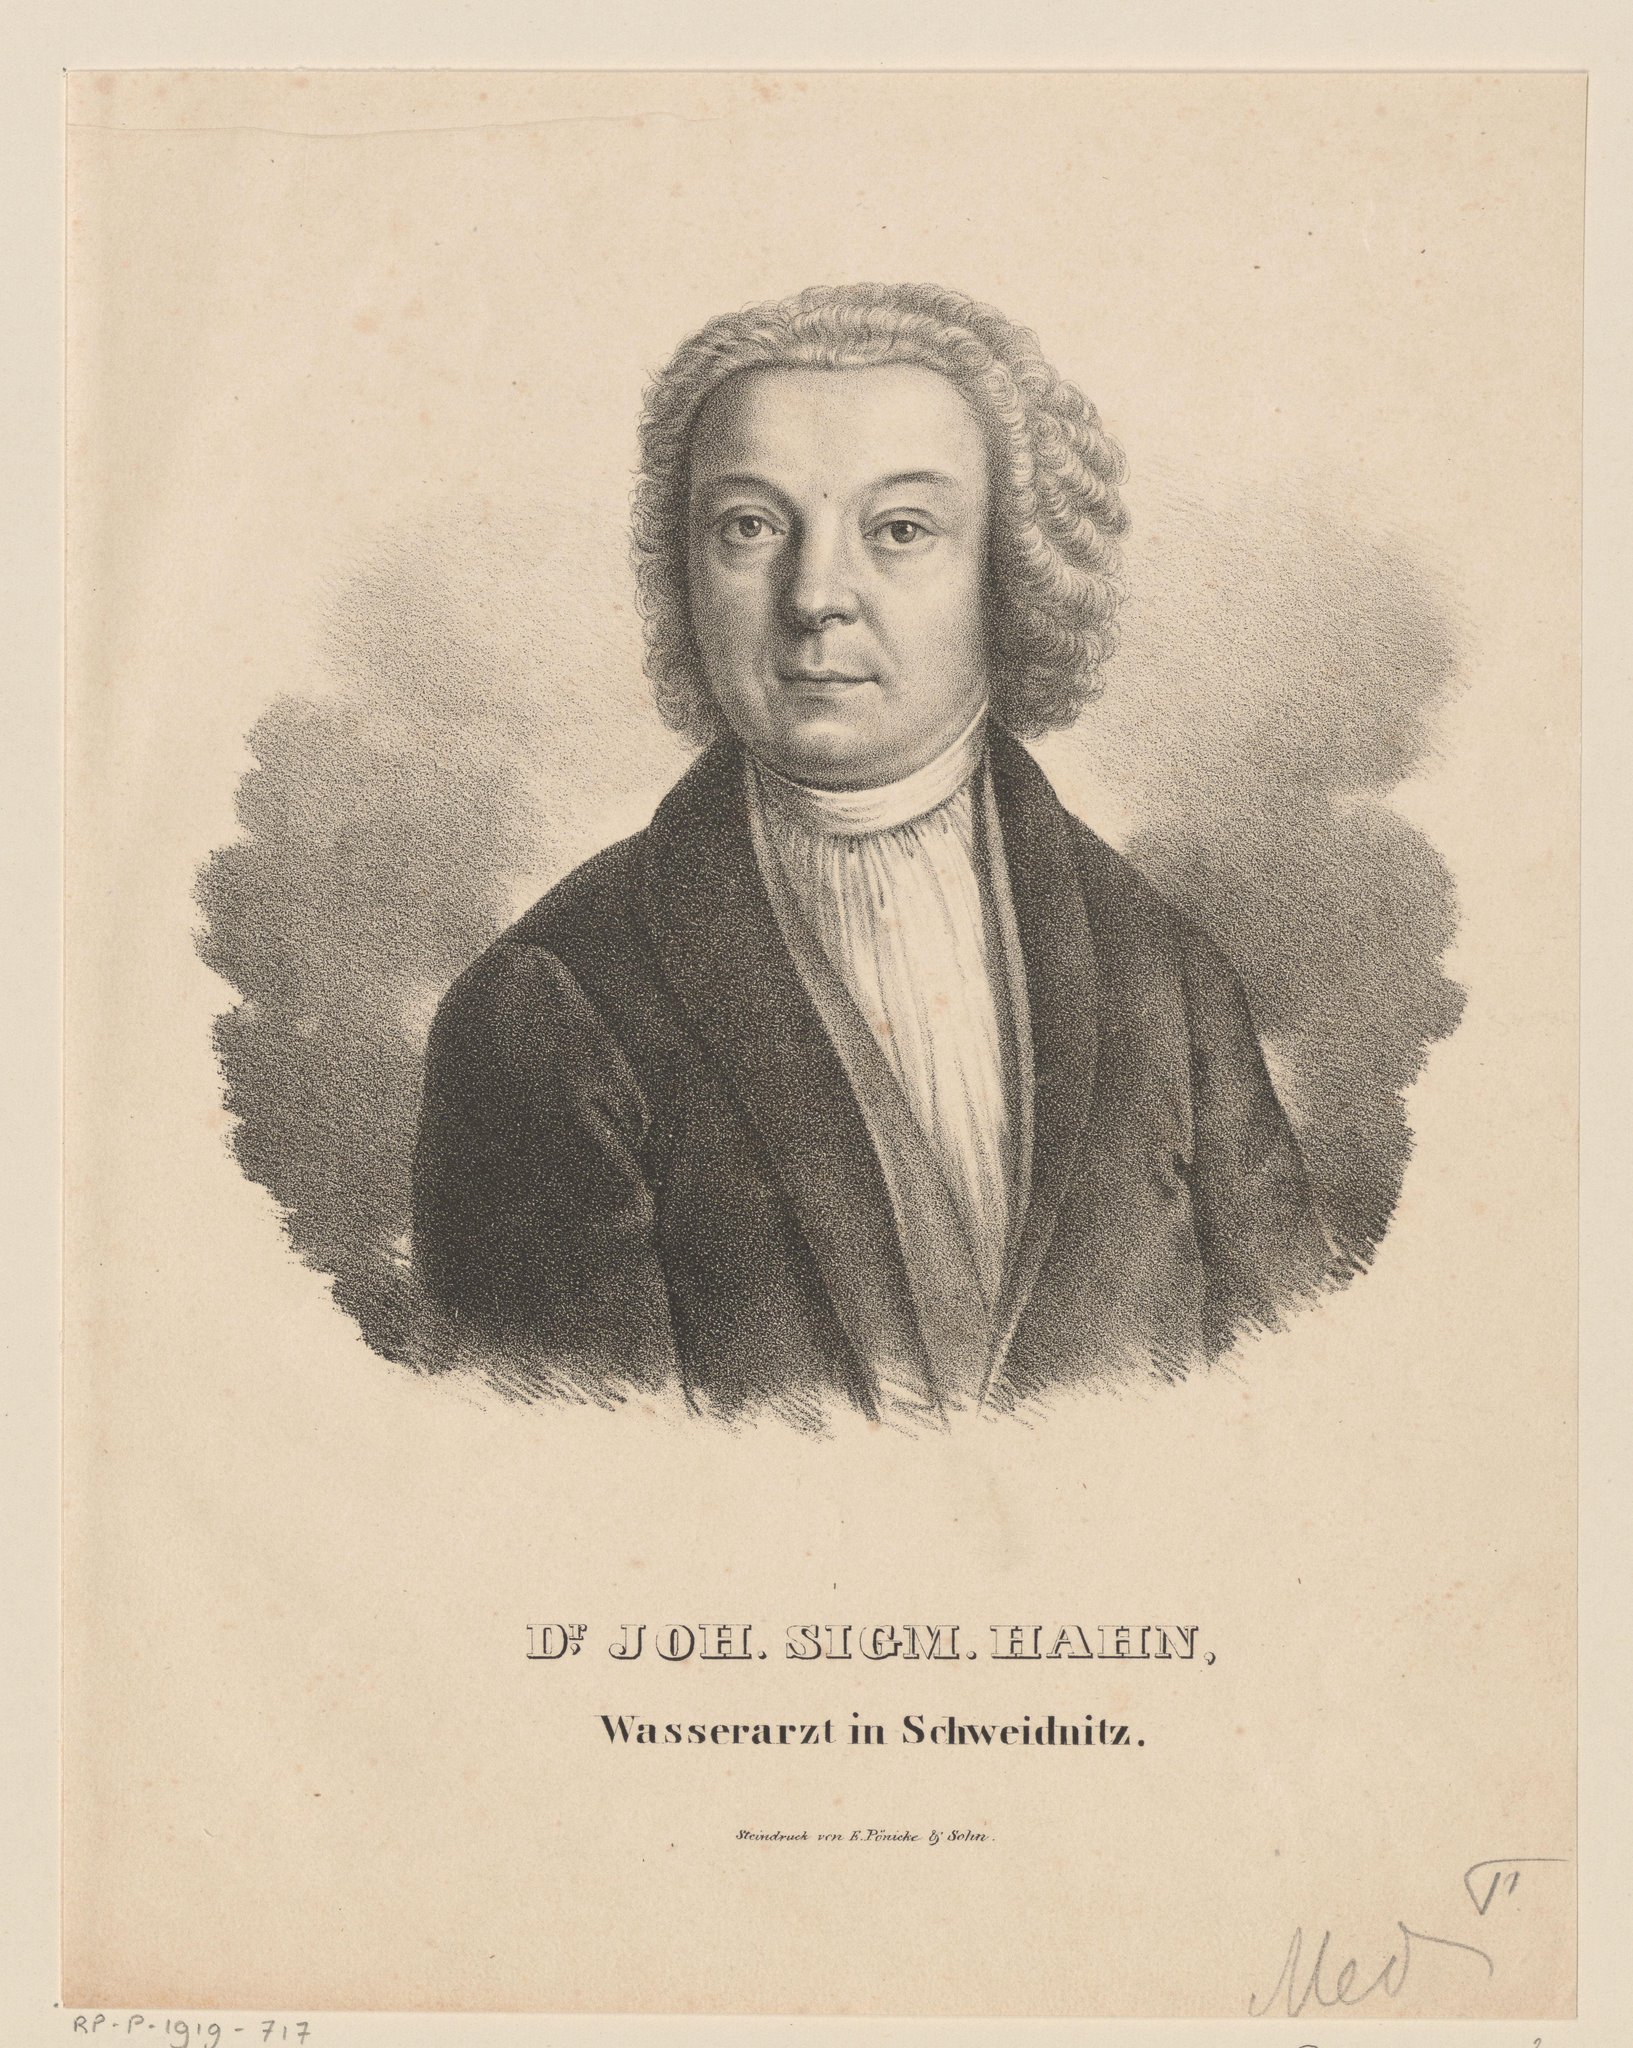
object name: print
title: Portret van Johann Siegmund Hahn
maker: Anonymous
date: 1840-1848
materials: paper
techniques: lithograph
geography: leipzig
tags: historical persons, physician, doctor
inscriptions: collector's mark: Lugt 2228